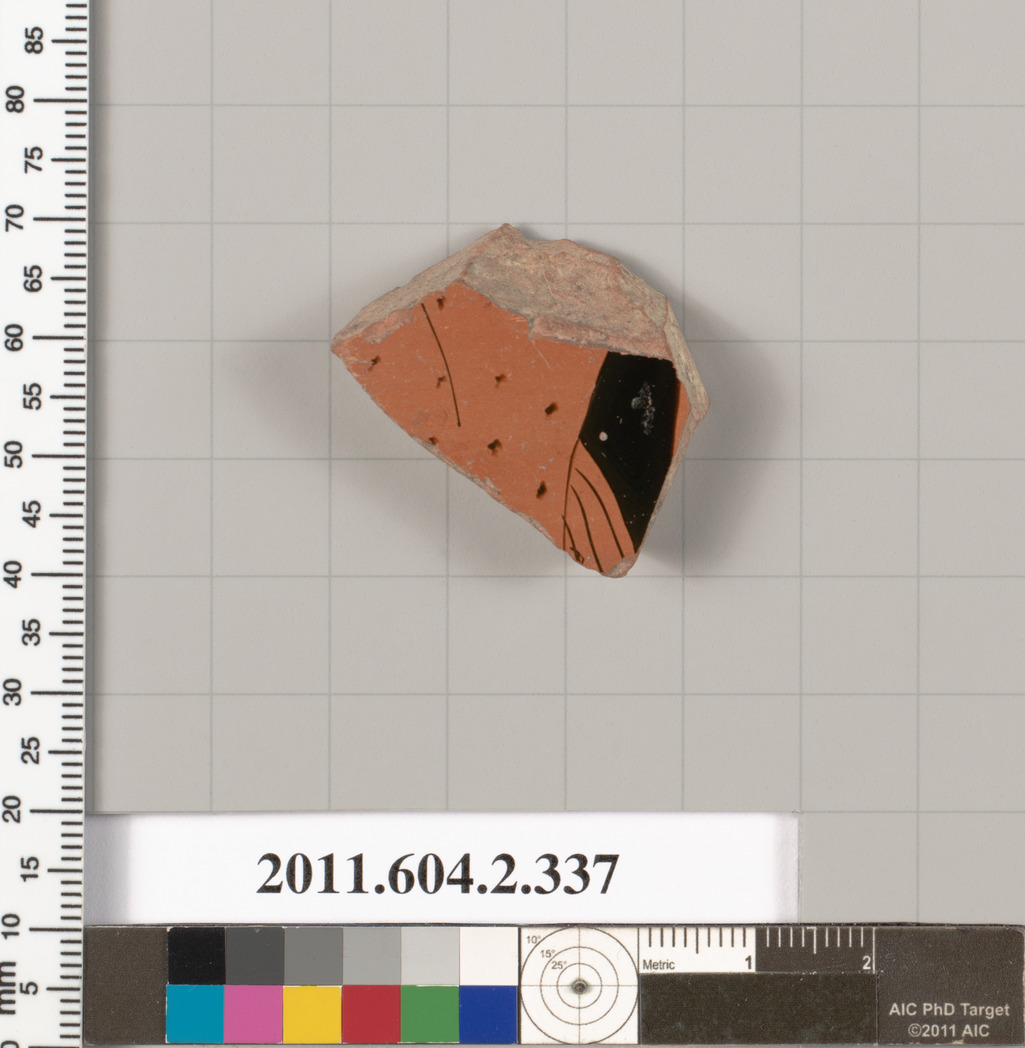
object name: column krater fragment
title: Terracotta fragment of a column-krater (bowl for mixing wine and water)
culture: greek, attic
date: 460-440 BCE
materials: terracotta